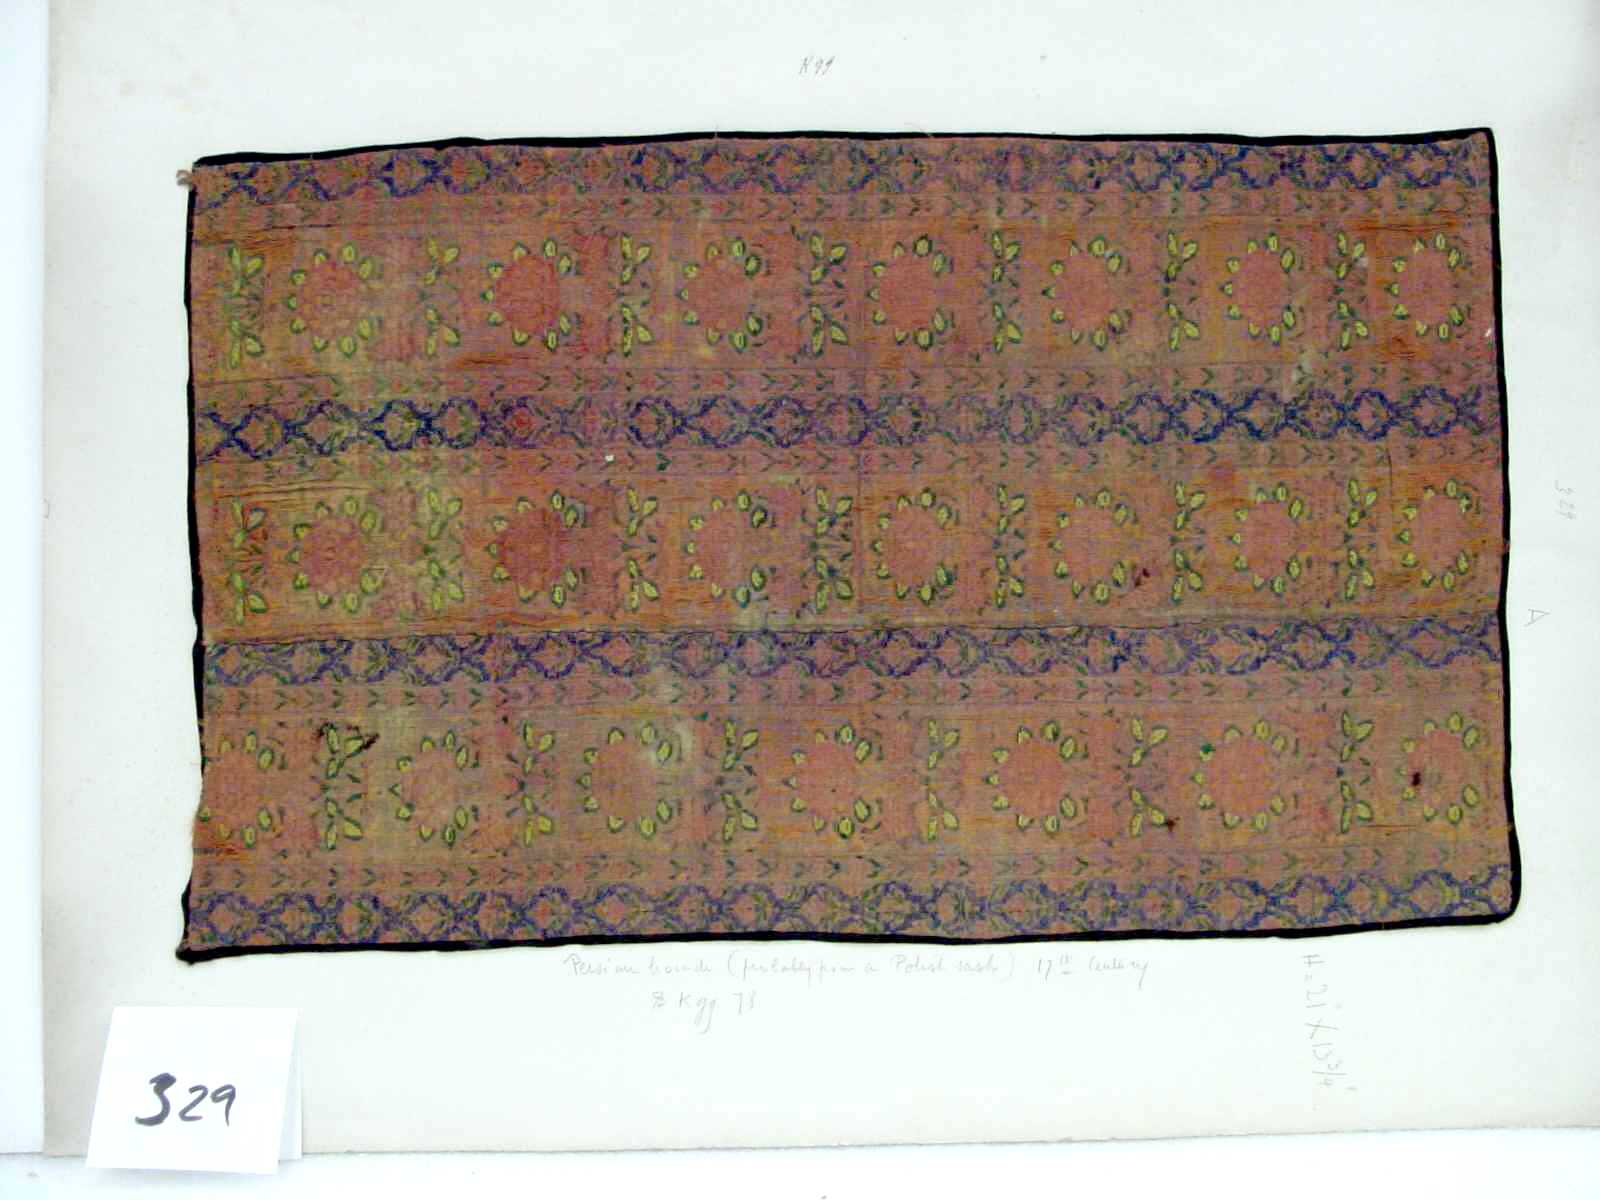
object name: textile fragment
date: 1601-1700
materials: silk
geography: iran